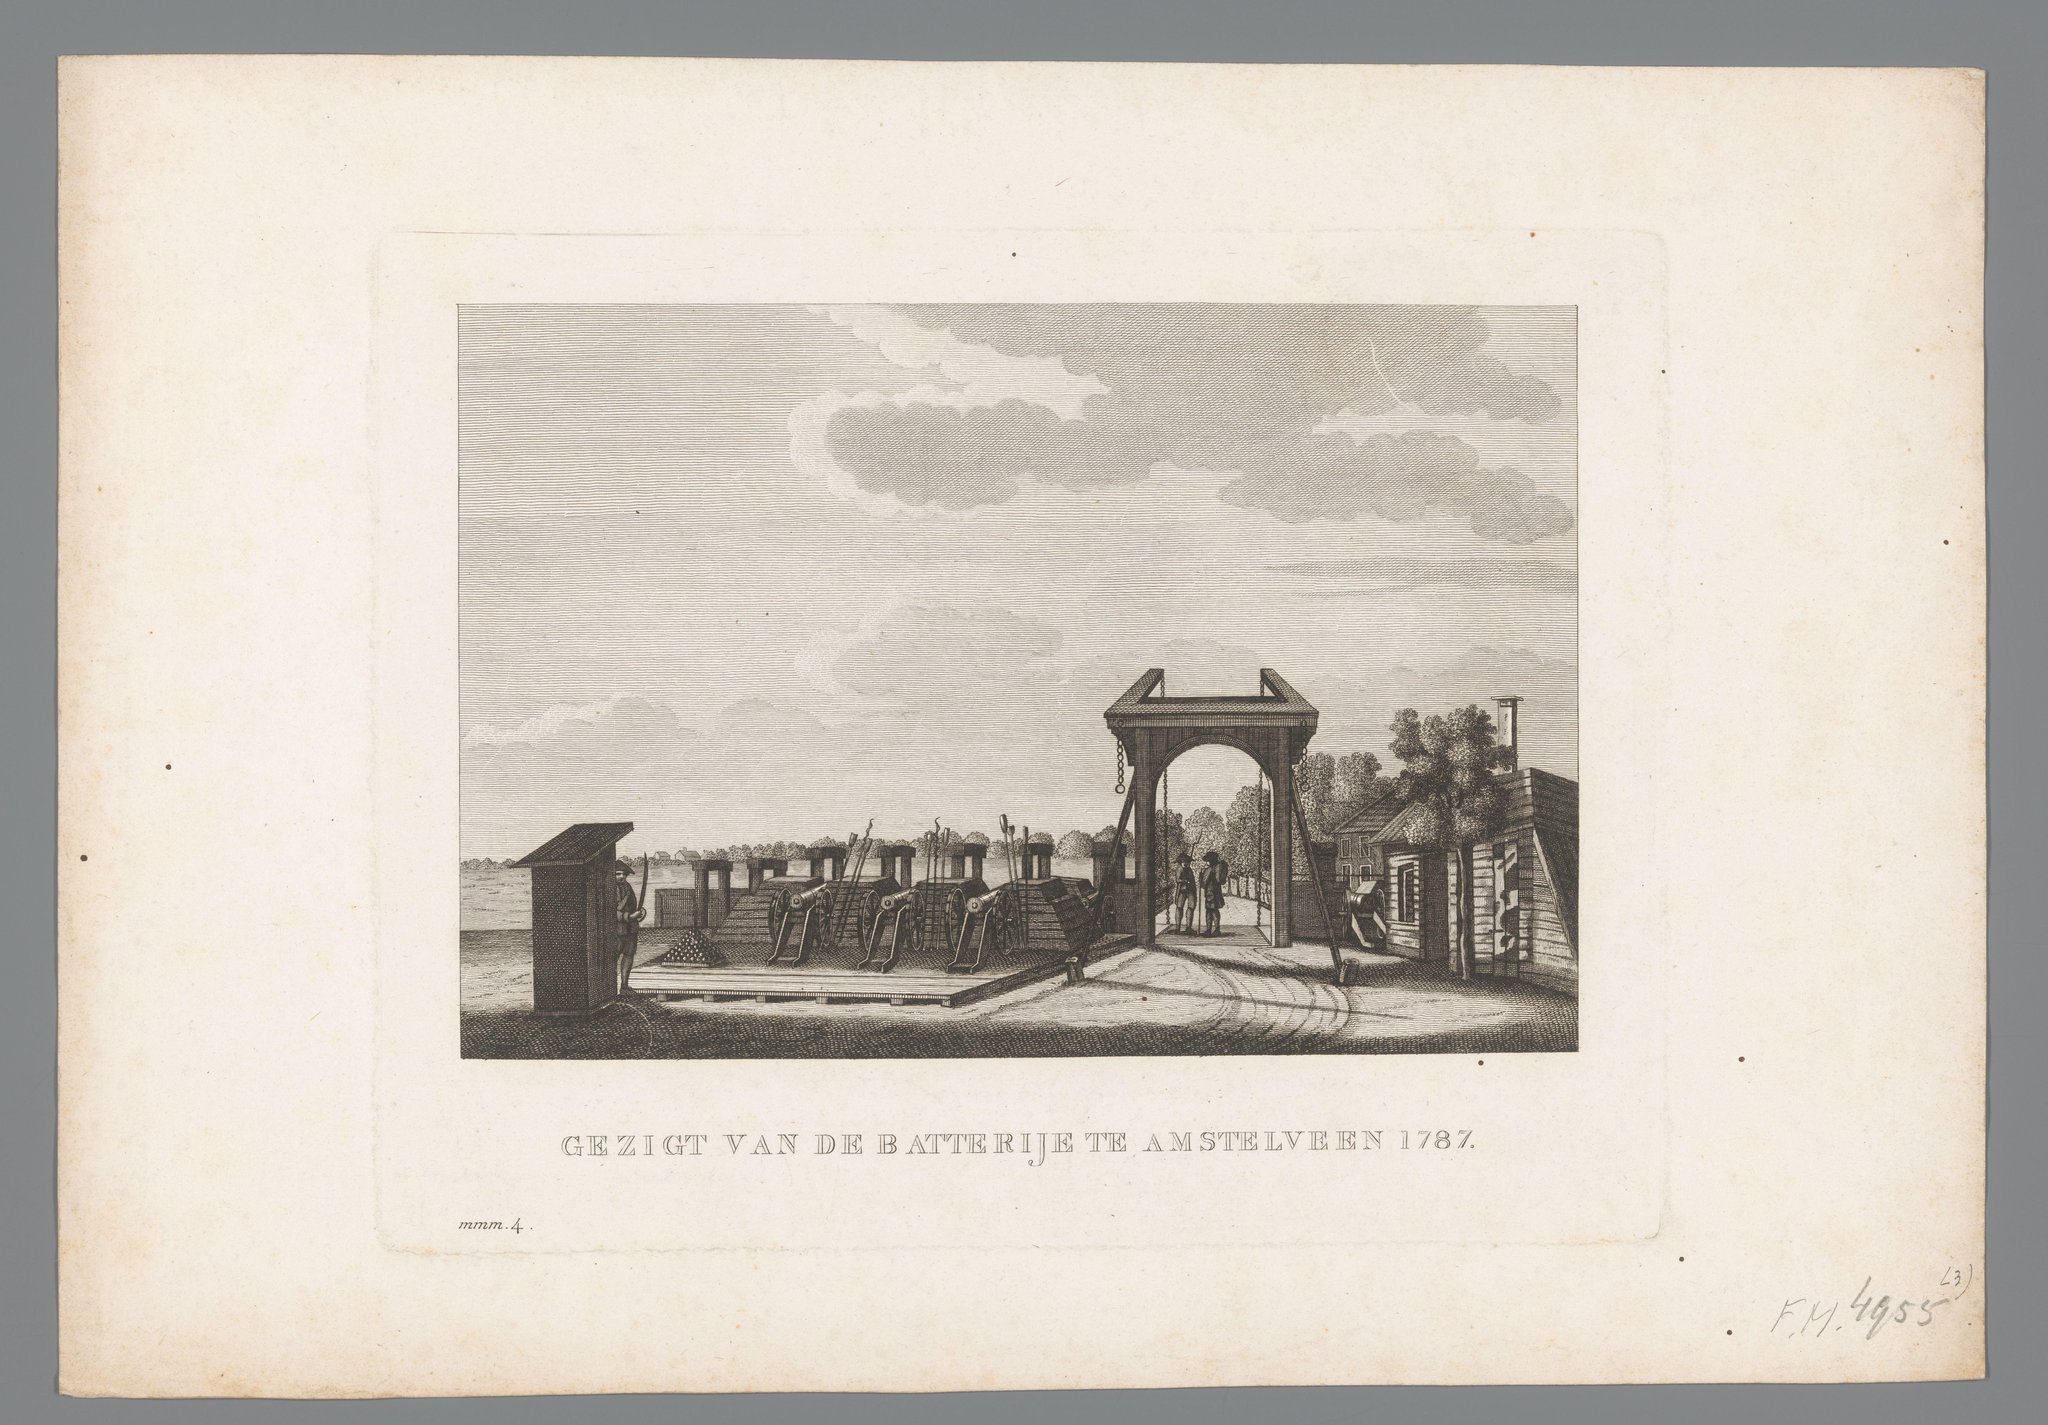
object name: print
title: Batterijen rondom Amsterdam in 1787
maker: Anonymous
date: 1787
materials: paper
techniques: engraving, etching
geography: northern netherlands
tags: defence of fortification or city, defensive measures (military)